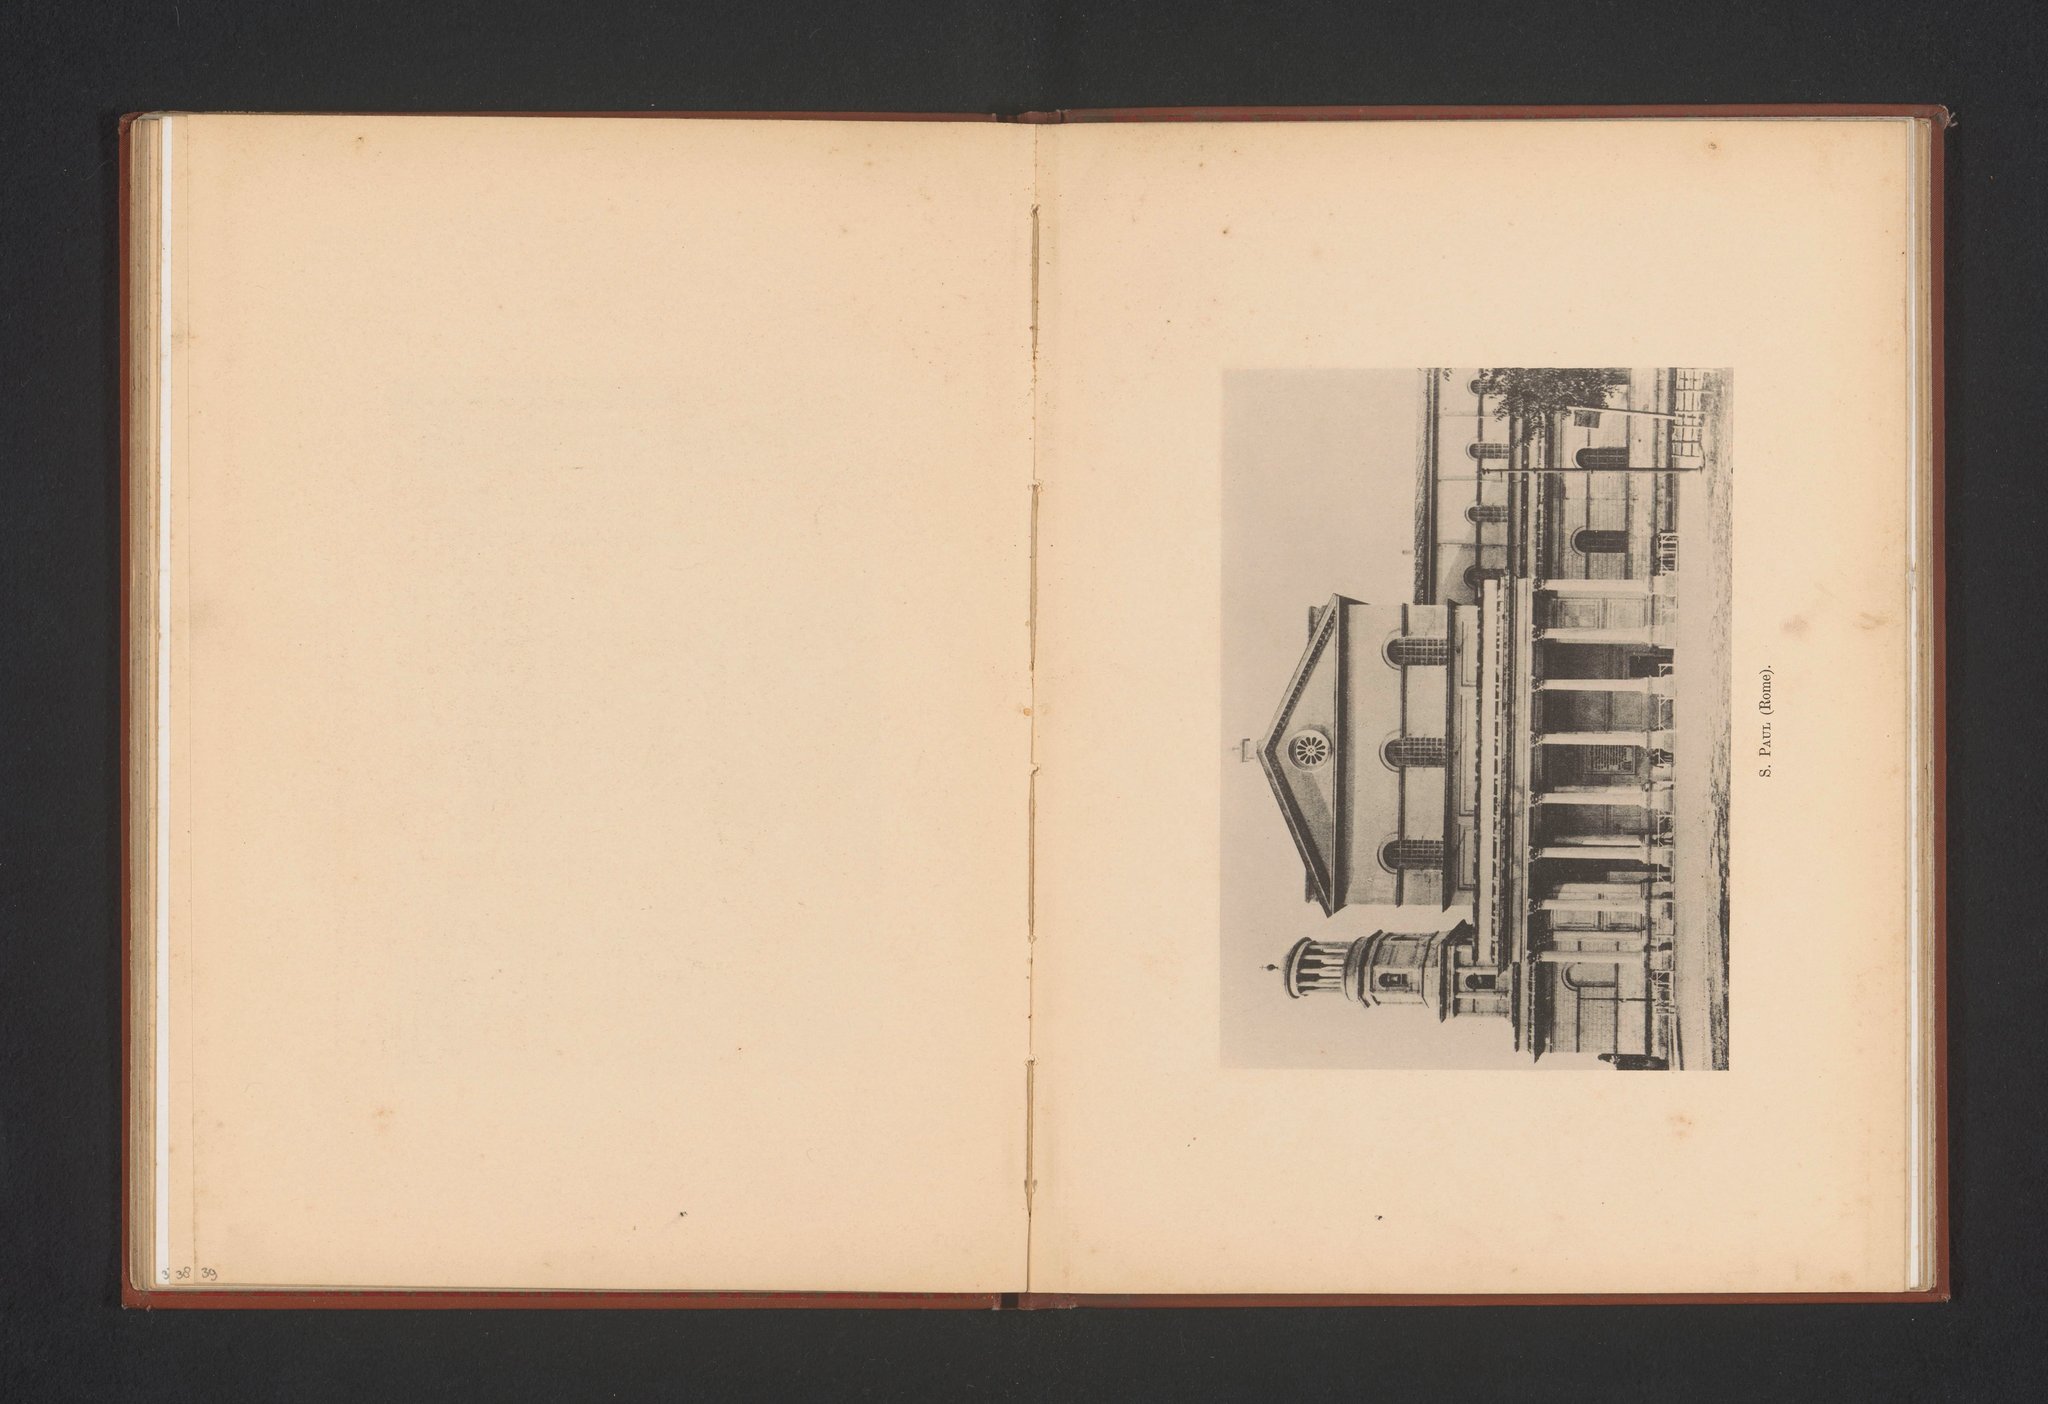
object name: page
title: S. Paul (Rome)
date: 1893-1898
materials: paper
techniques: photograph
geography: rome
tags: church (exterior)